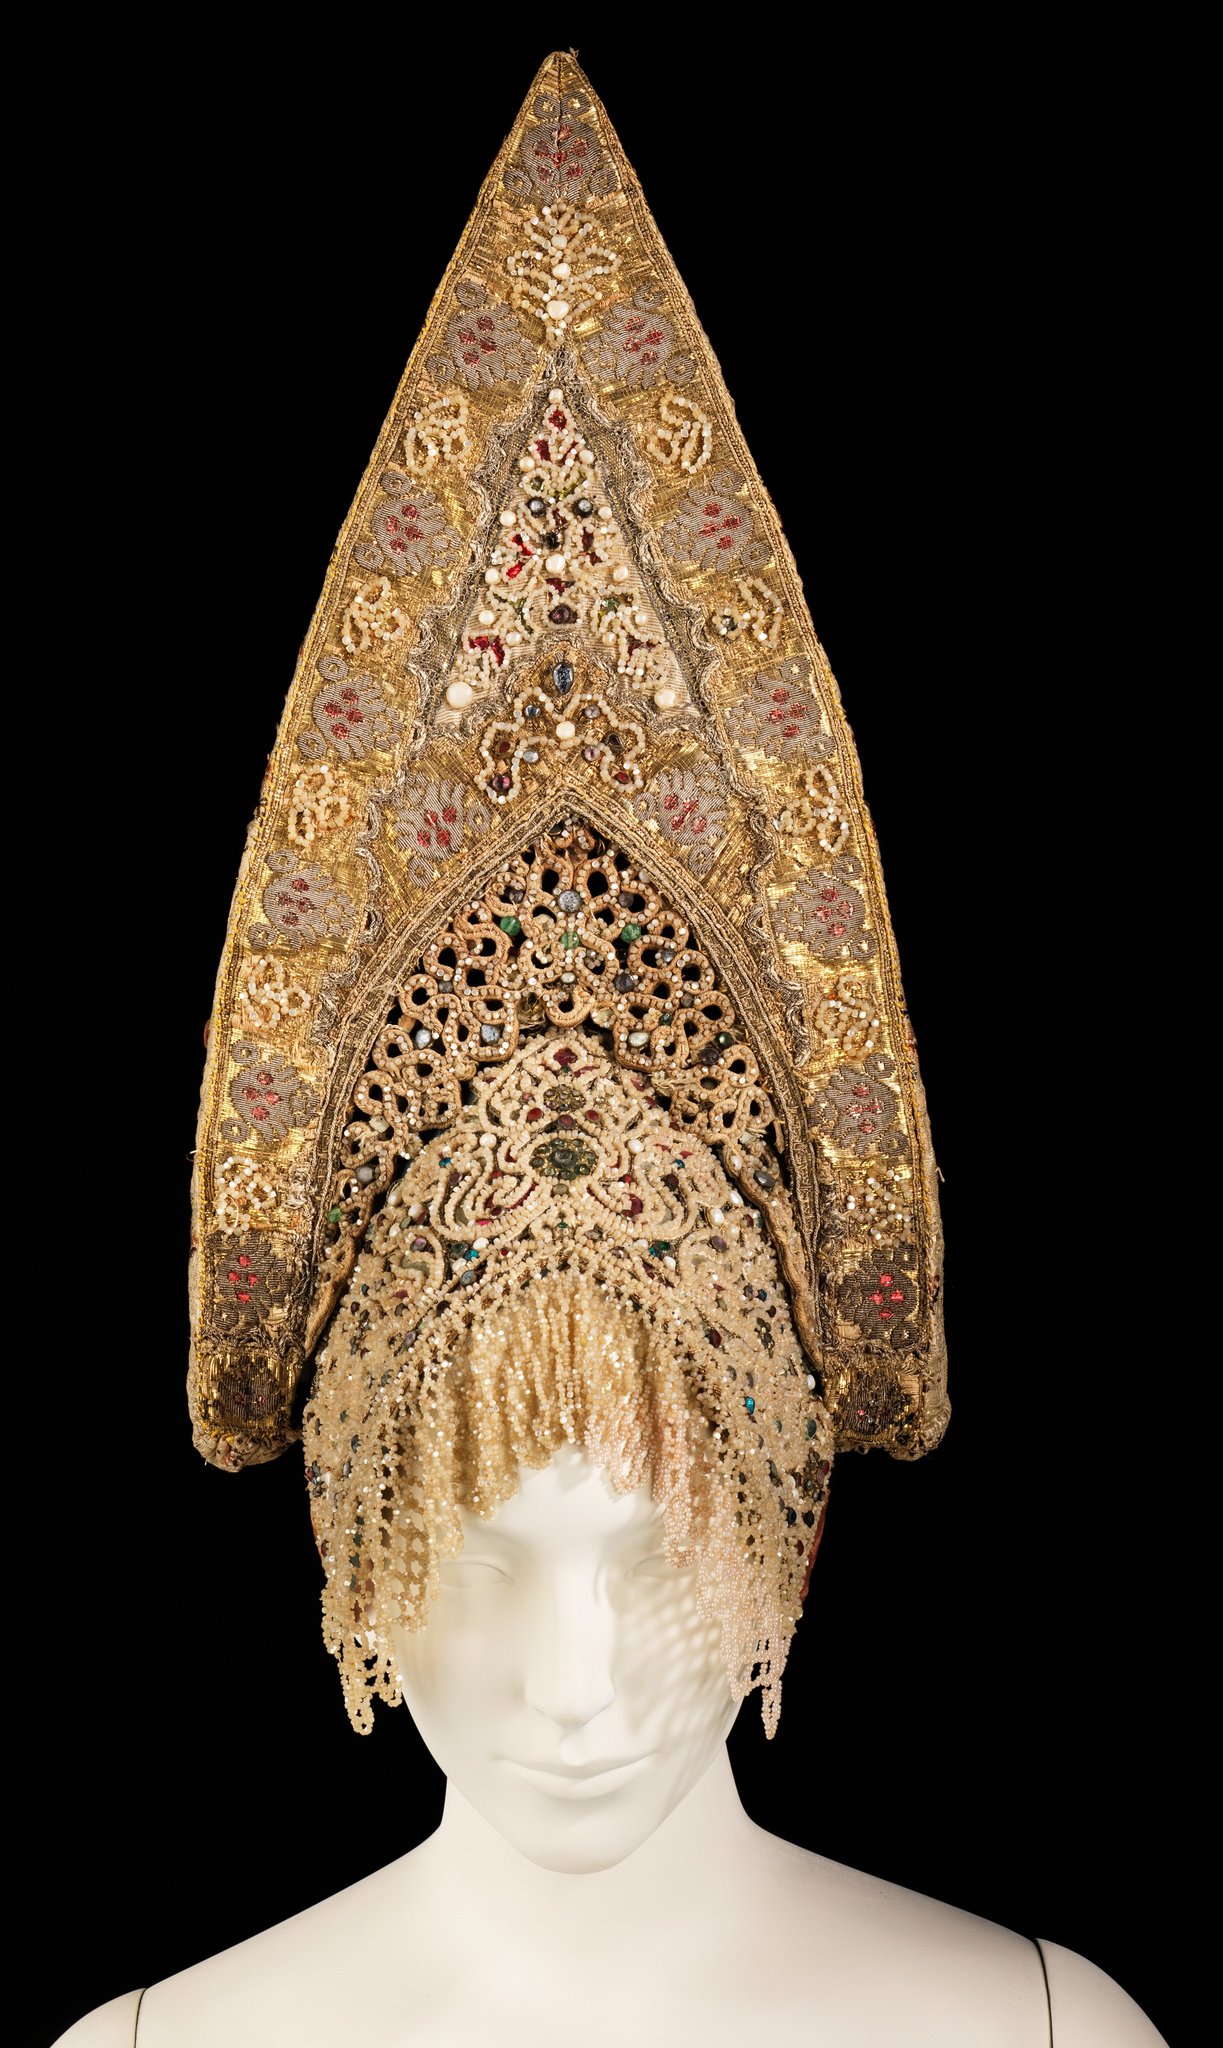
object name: headdress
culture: russian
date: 1776-1800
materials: cotton, glass, metal, mother of pearl, paper, silk